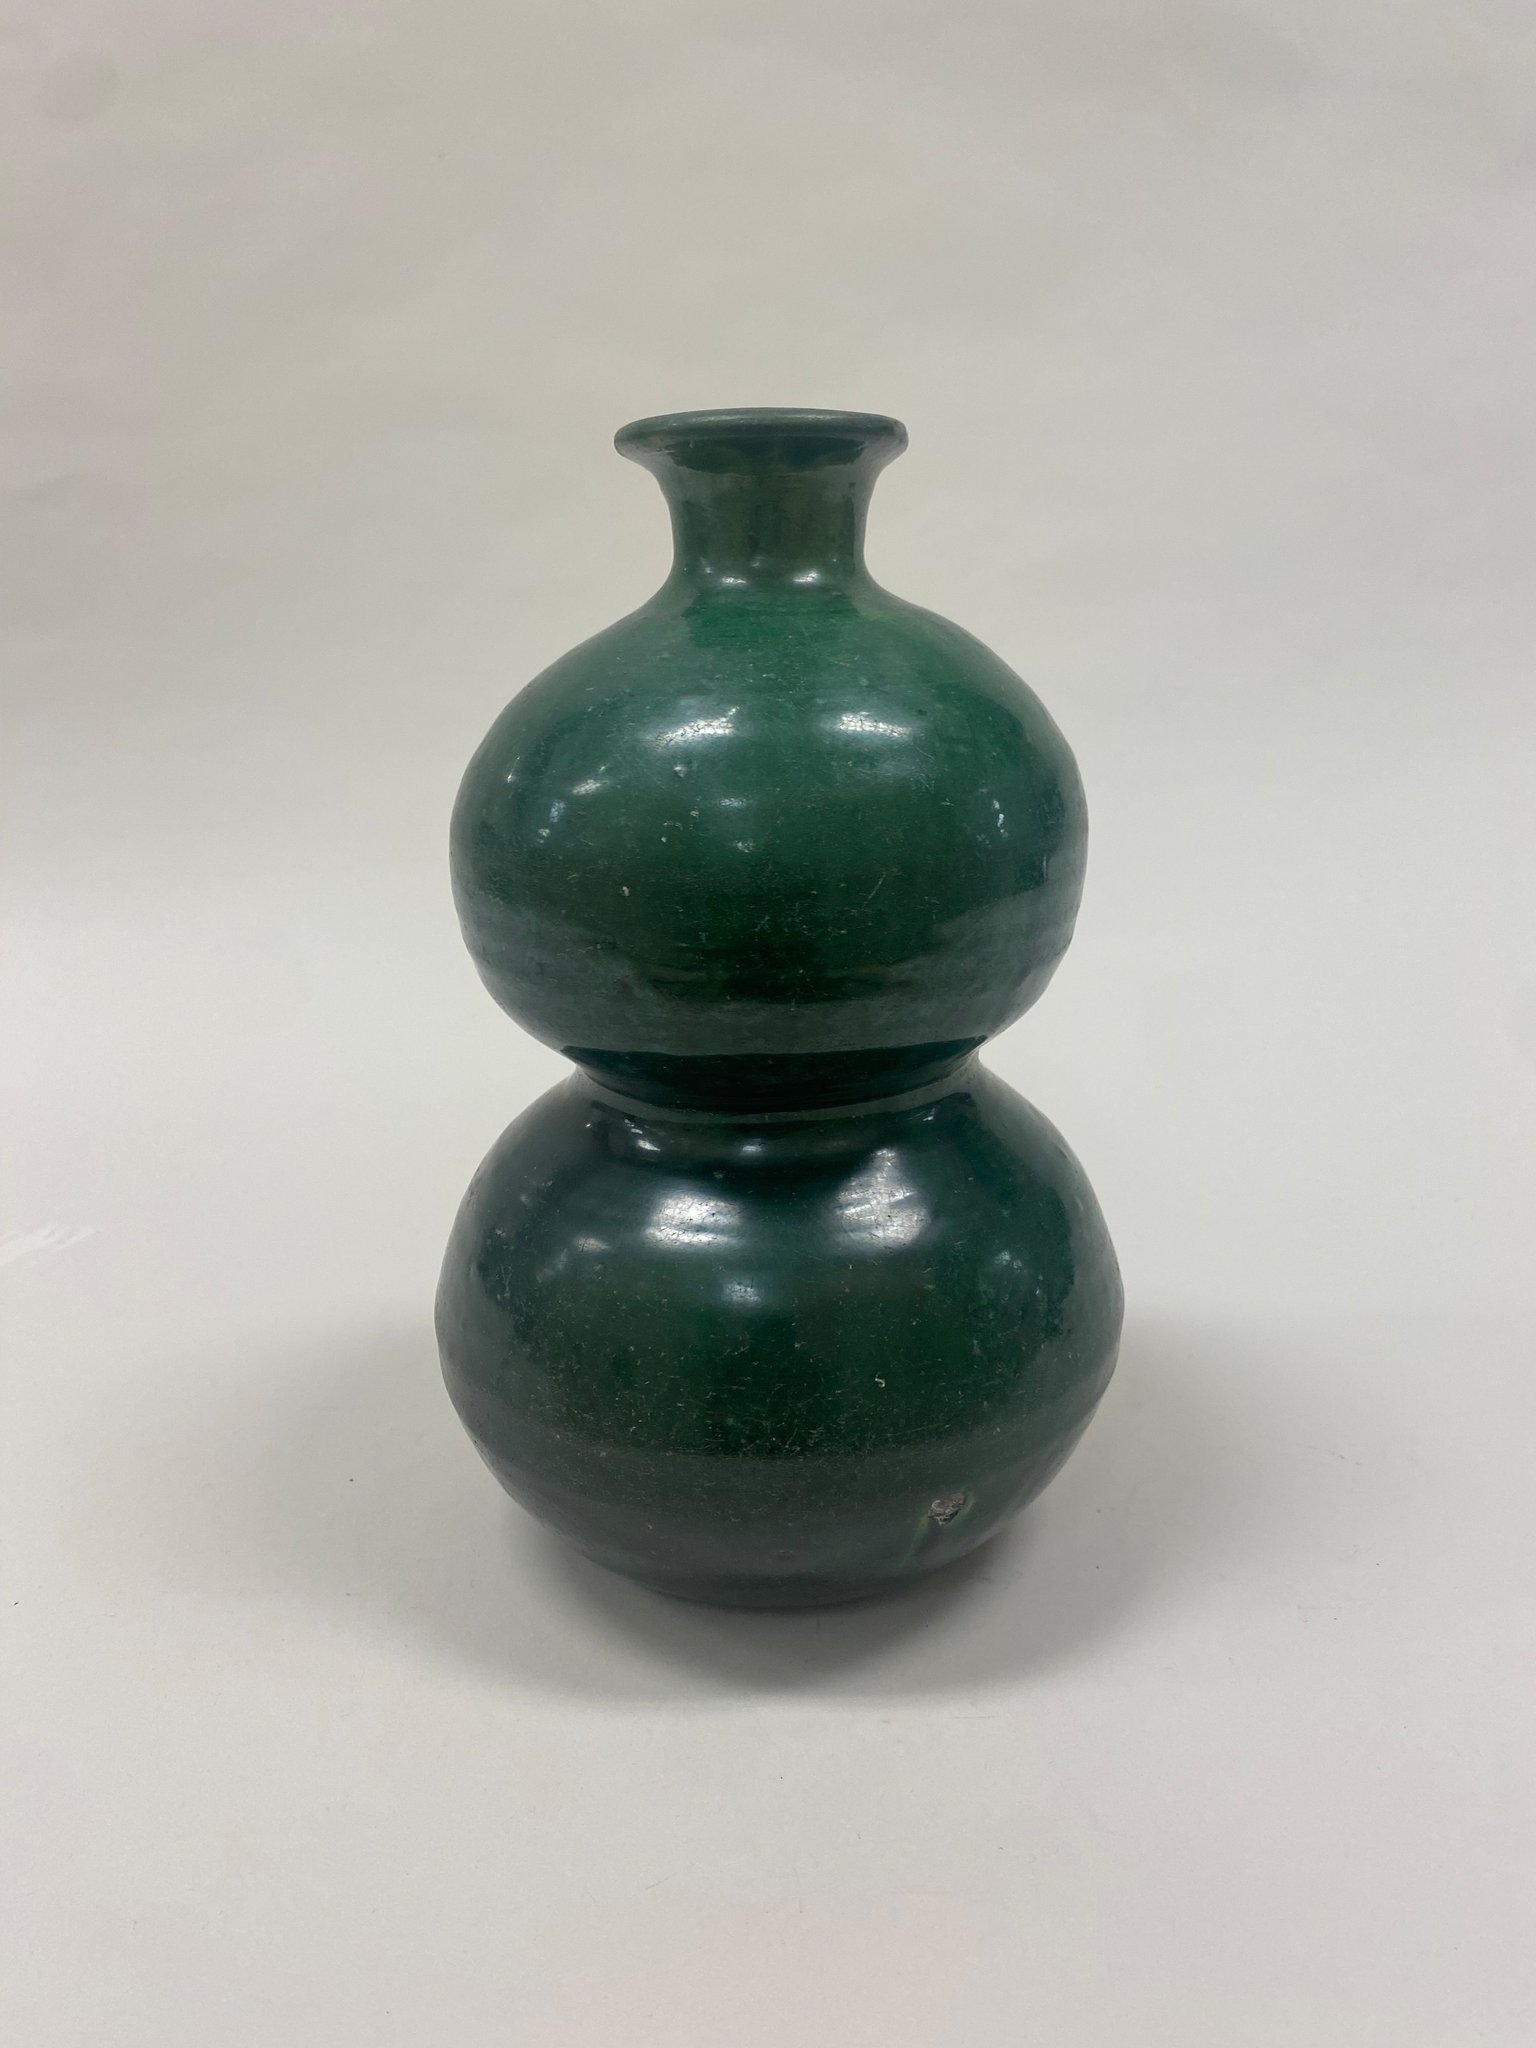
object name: bottle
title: Gourd-shaped bottle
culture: chinese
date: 1501-1600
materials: glaze, stoneware